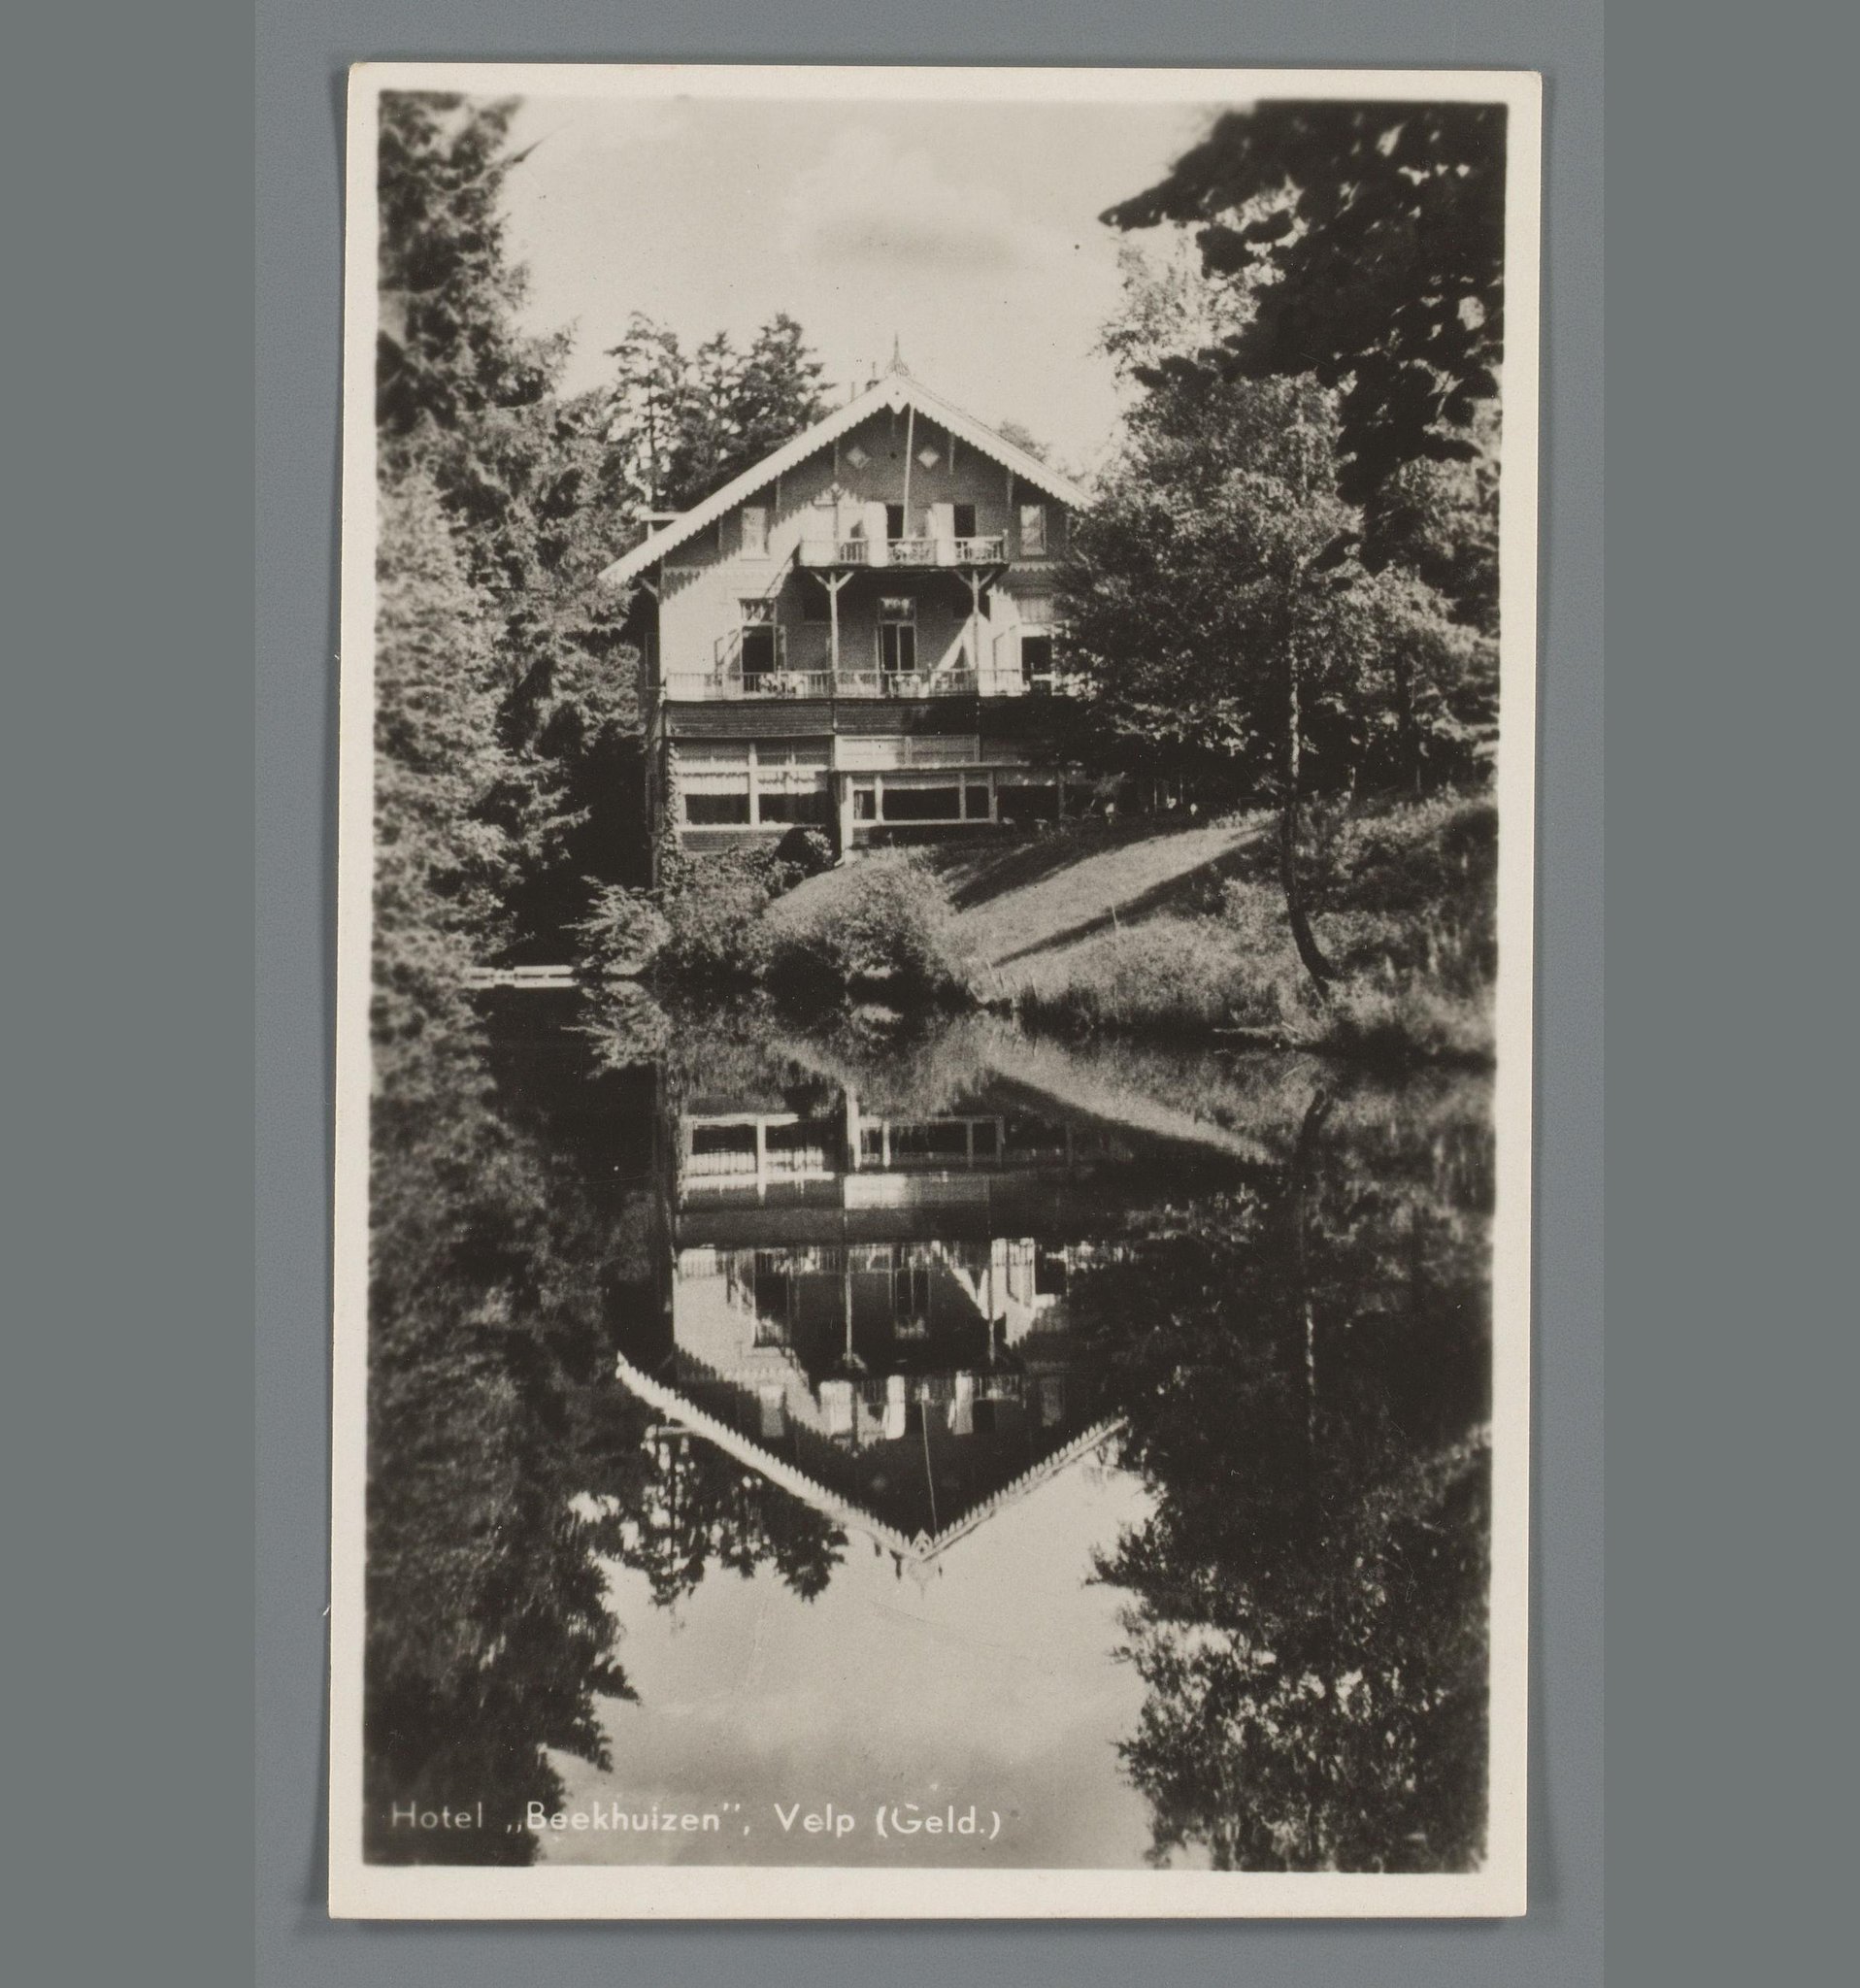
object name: photograph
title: Hotel "Beekhuizen", Velp (Geld.)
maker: Anonymous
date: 1930-1950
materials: paper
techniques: gelatin silver print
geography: velp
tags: hotel, hostelry, inn